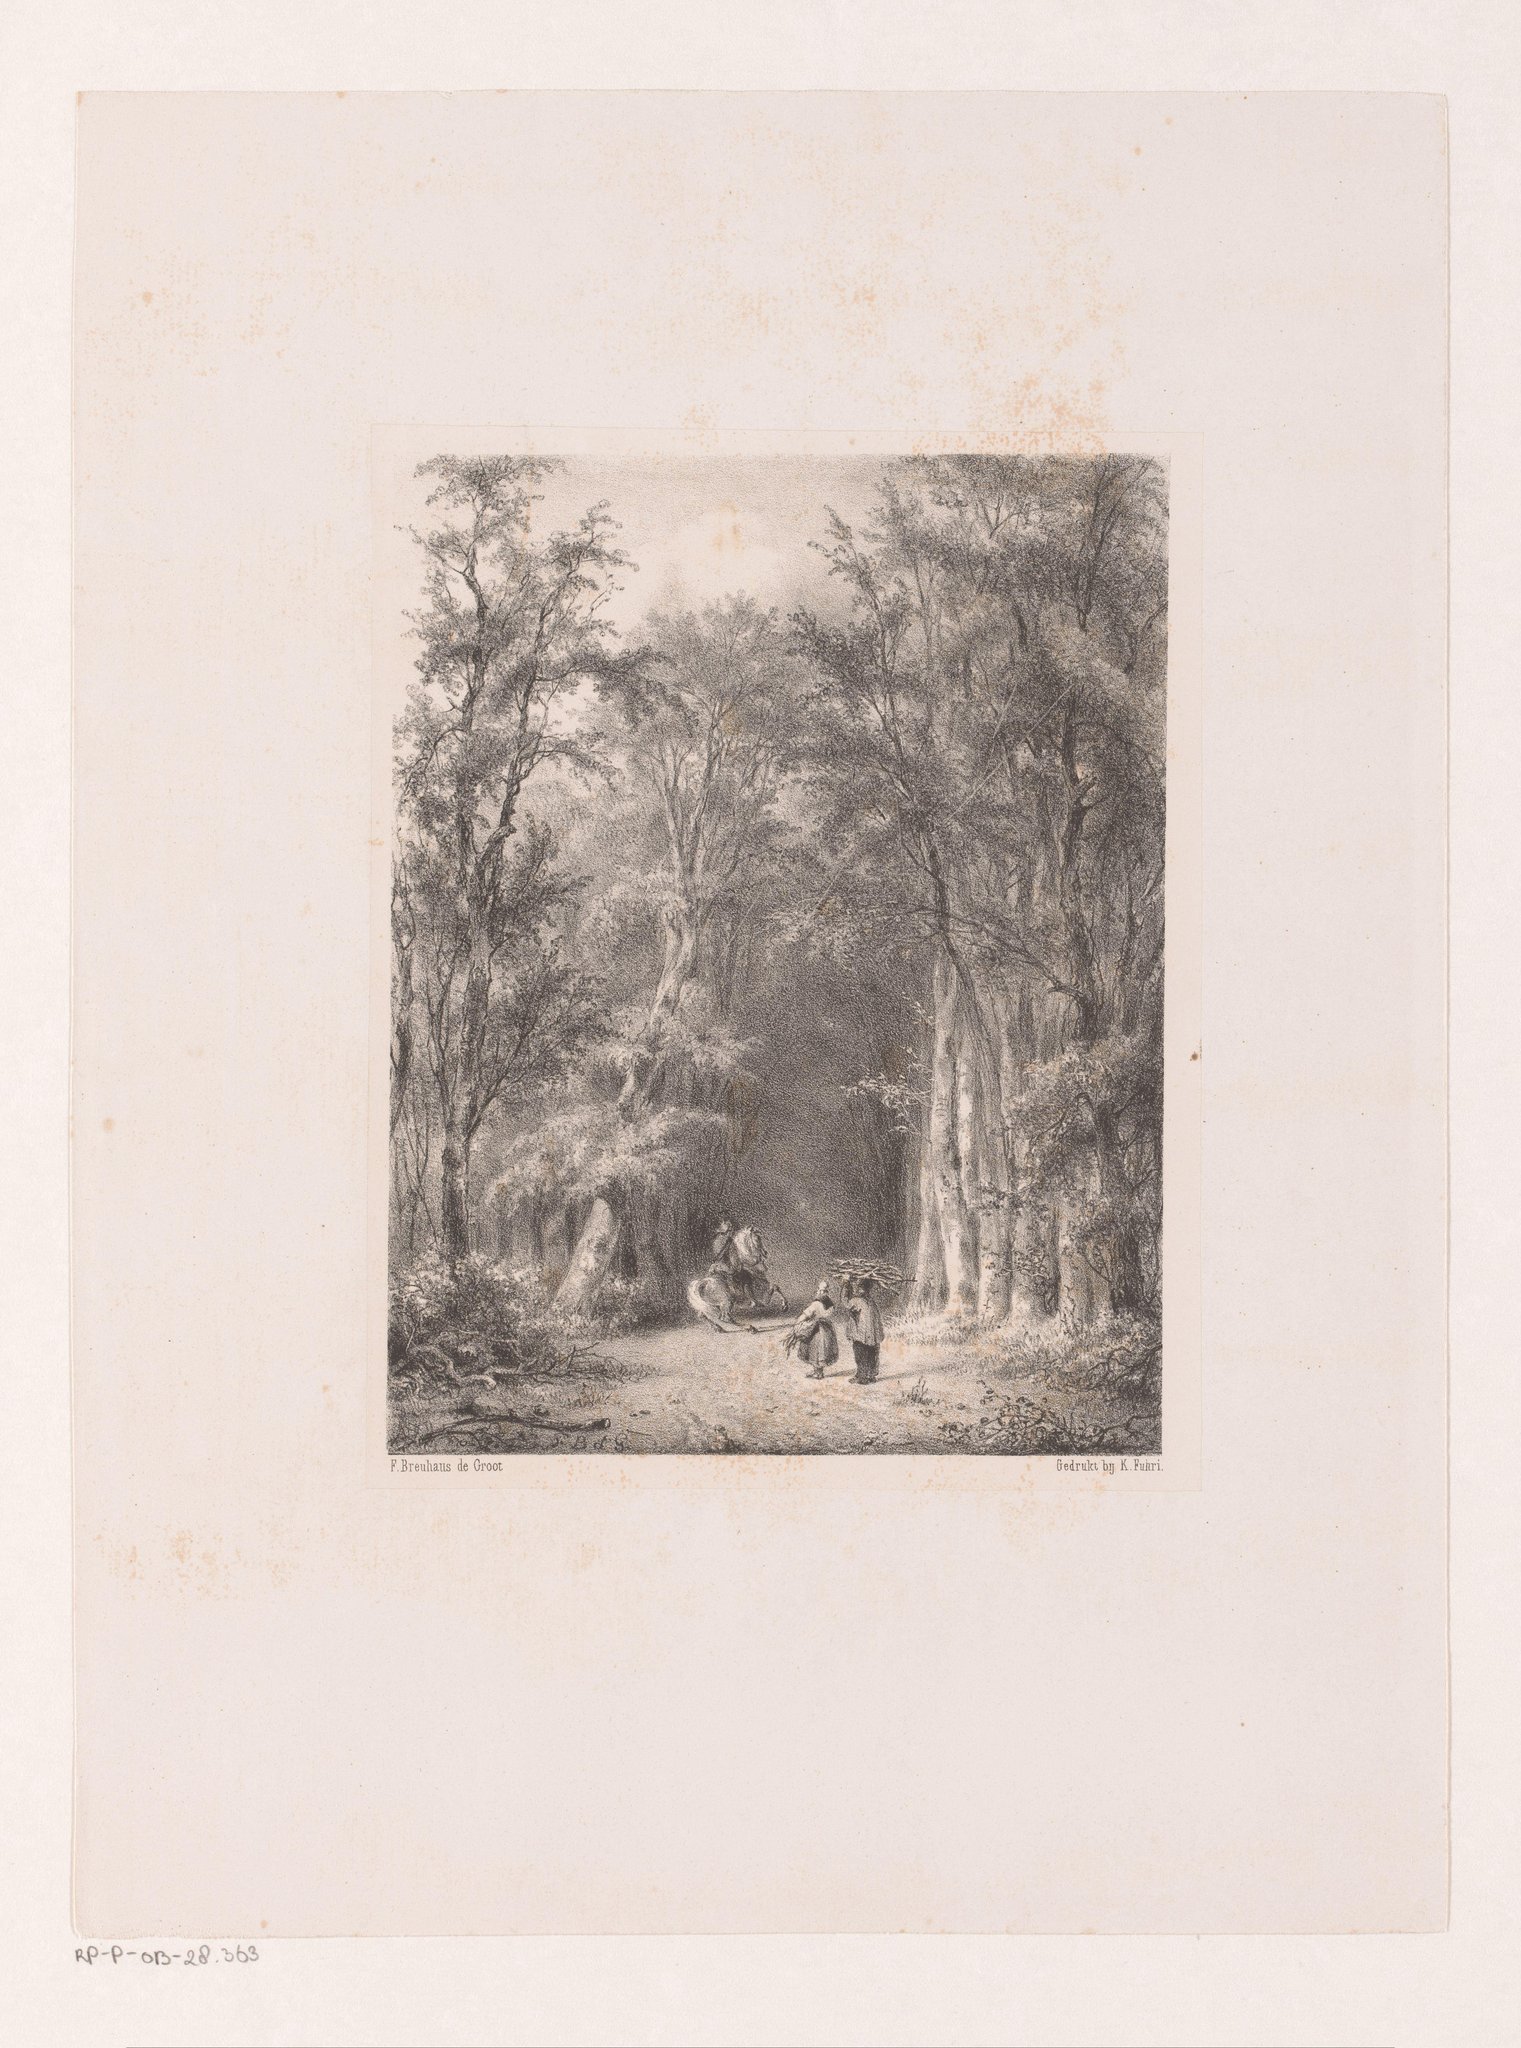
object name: print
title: Houtsprokkelaars en ruiter in het bos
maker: frans breuhaus de groot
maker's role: draughtsman, print maker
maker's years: 1796-1875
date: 1837-1855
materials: paper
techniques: lithograph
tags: riding a horse, ass, or mule; rider, horseman, woodgathering, woodgatherer, forest, wood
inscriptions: collector's mark: Lugt 2228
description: Een van de twee sprokkelaars heeft een bos hout op zijn hoofd. Het paard is in galop.